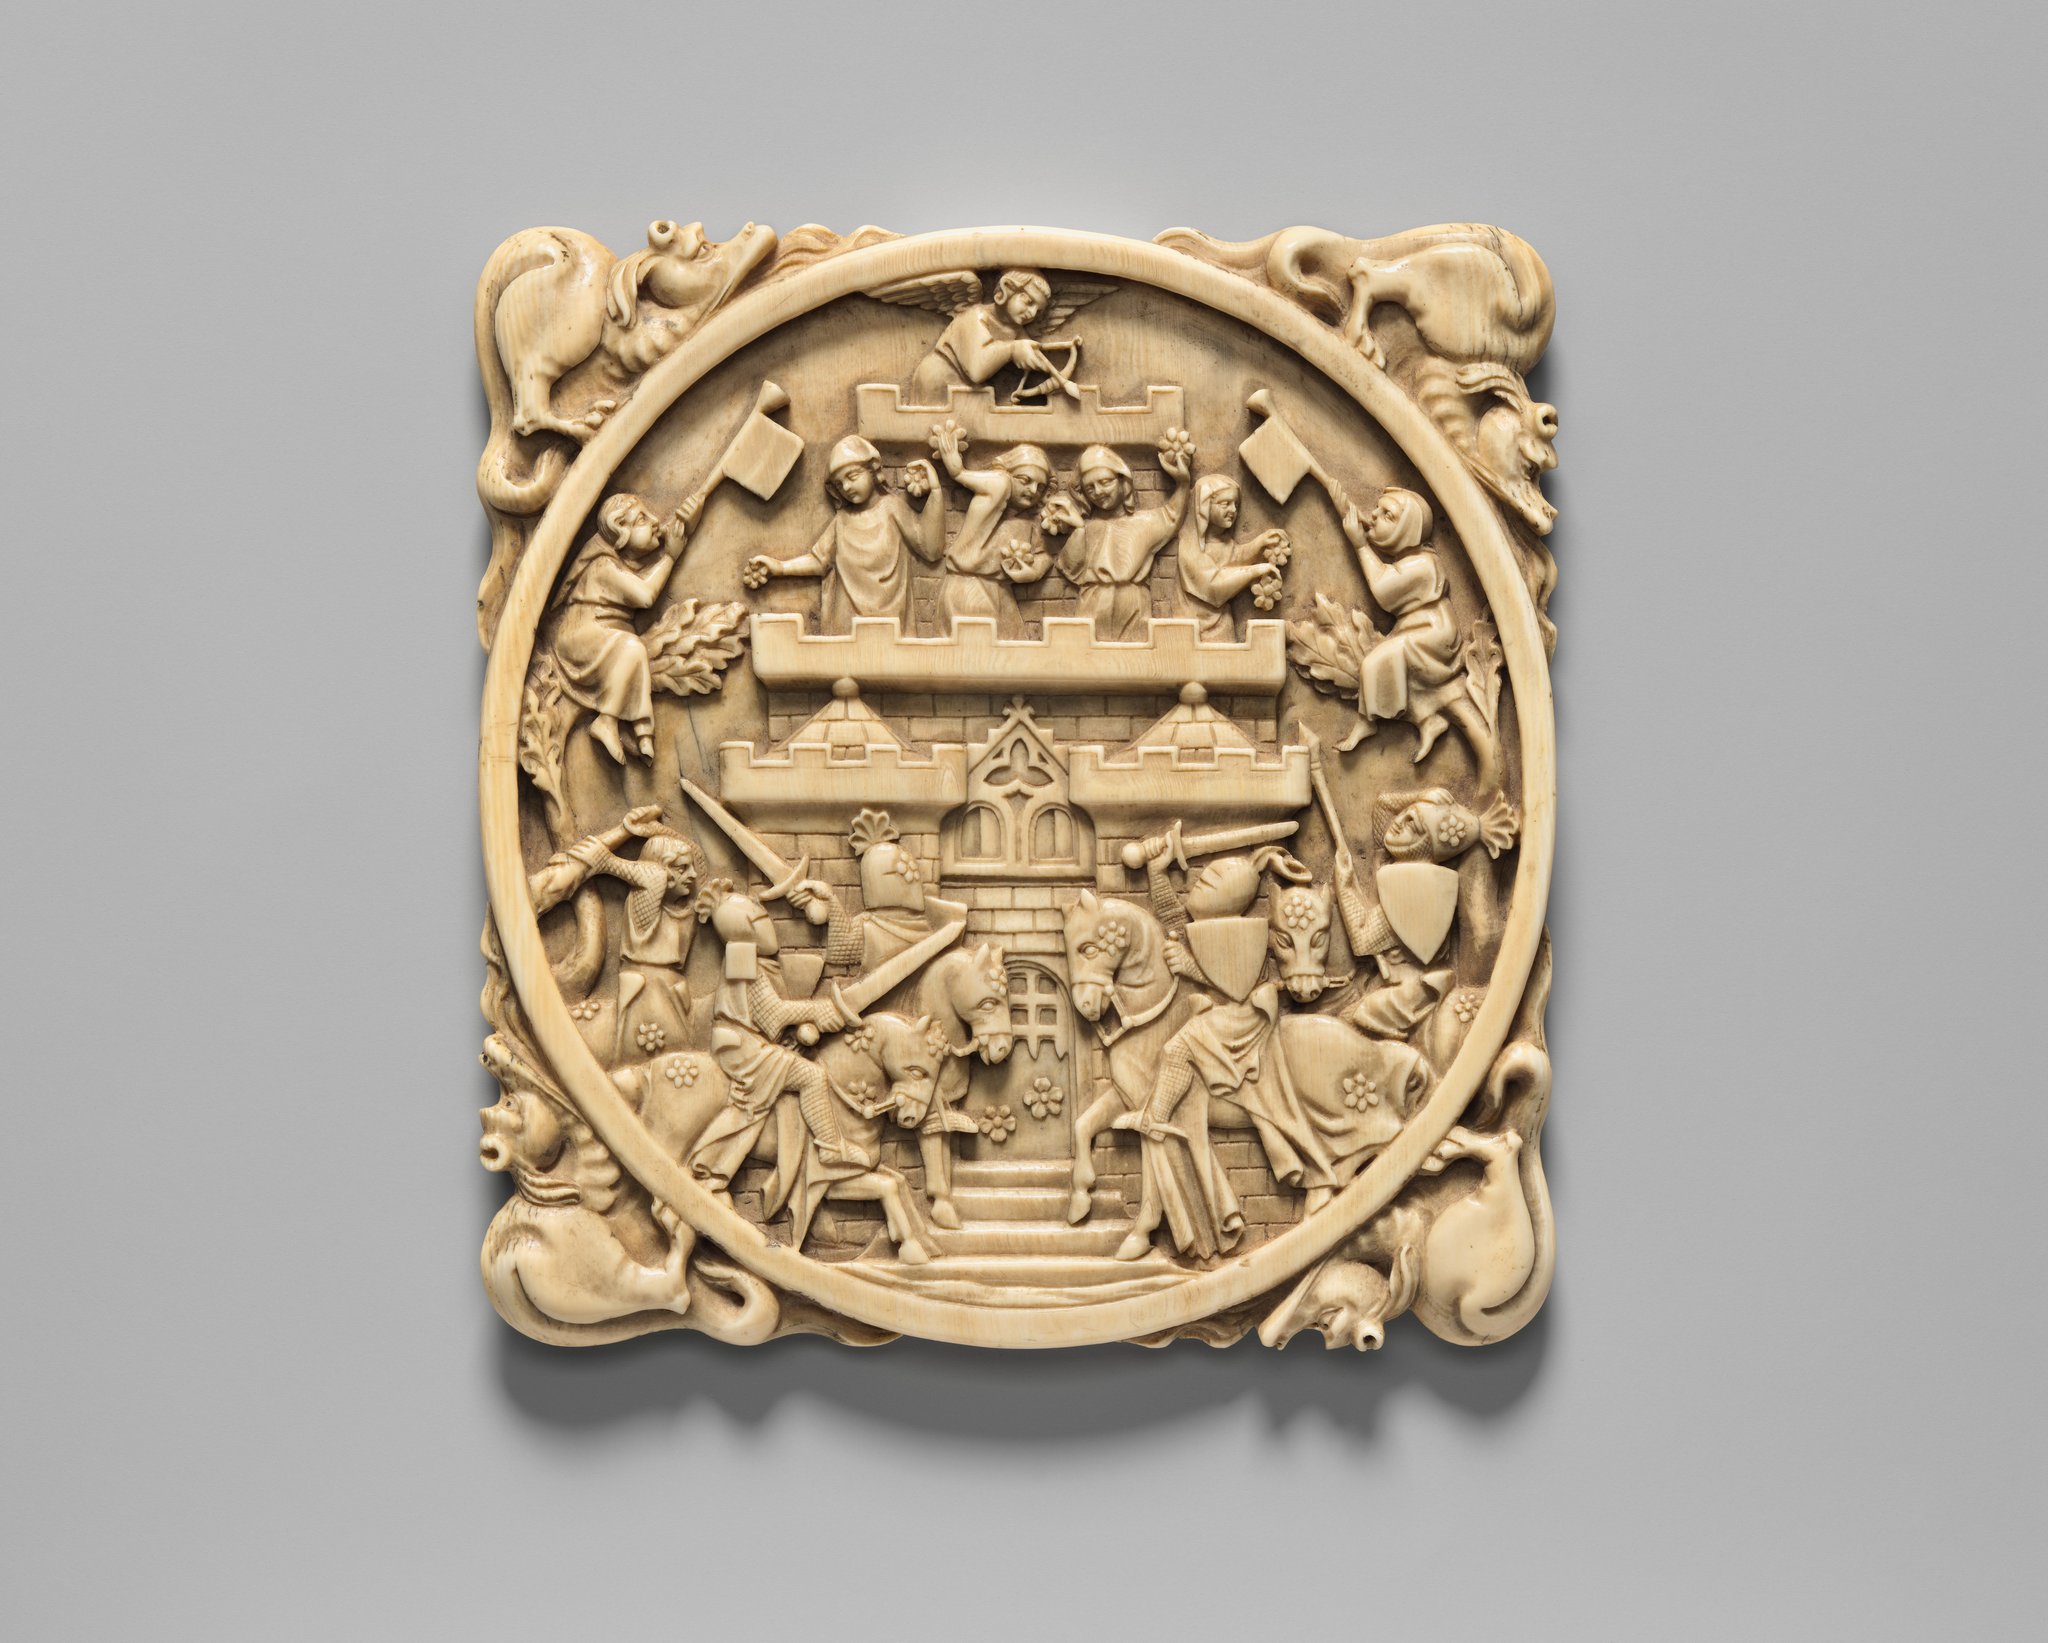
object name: mirror with cover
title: Mirror Cover with the Attack on the Castle of Love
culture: european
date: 1801-1900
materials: ivory, plastic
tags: battles,swords,men,dragons,horses